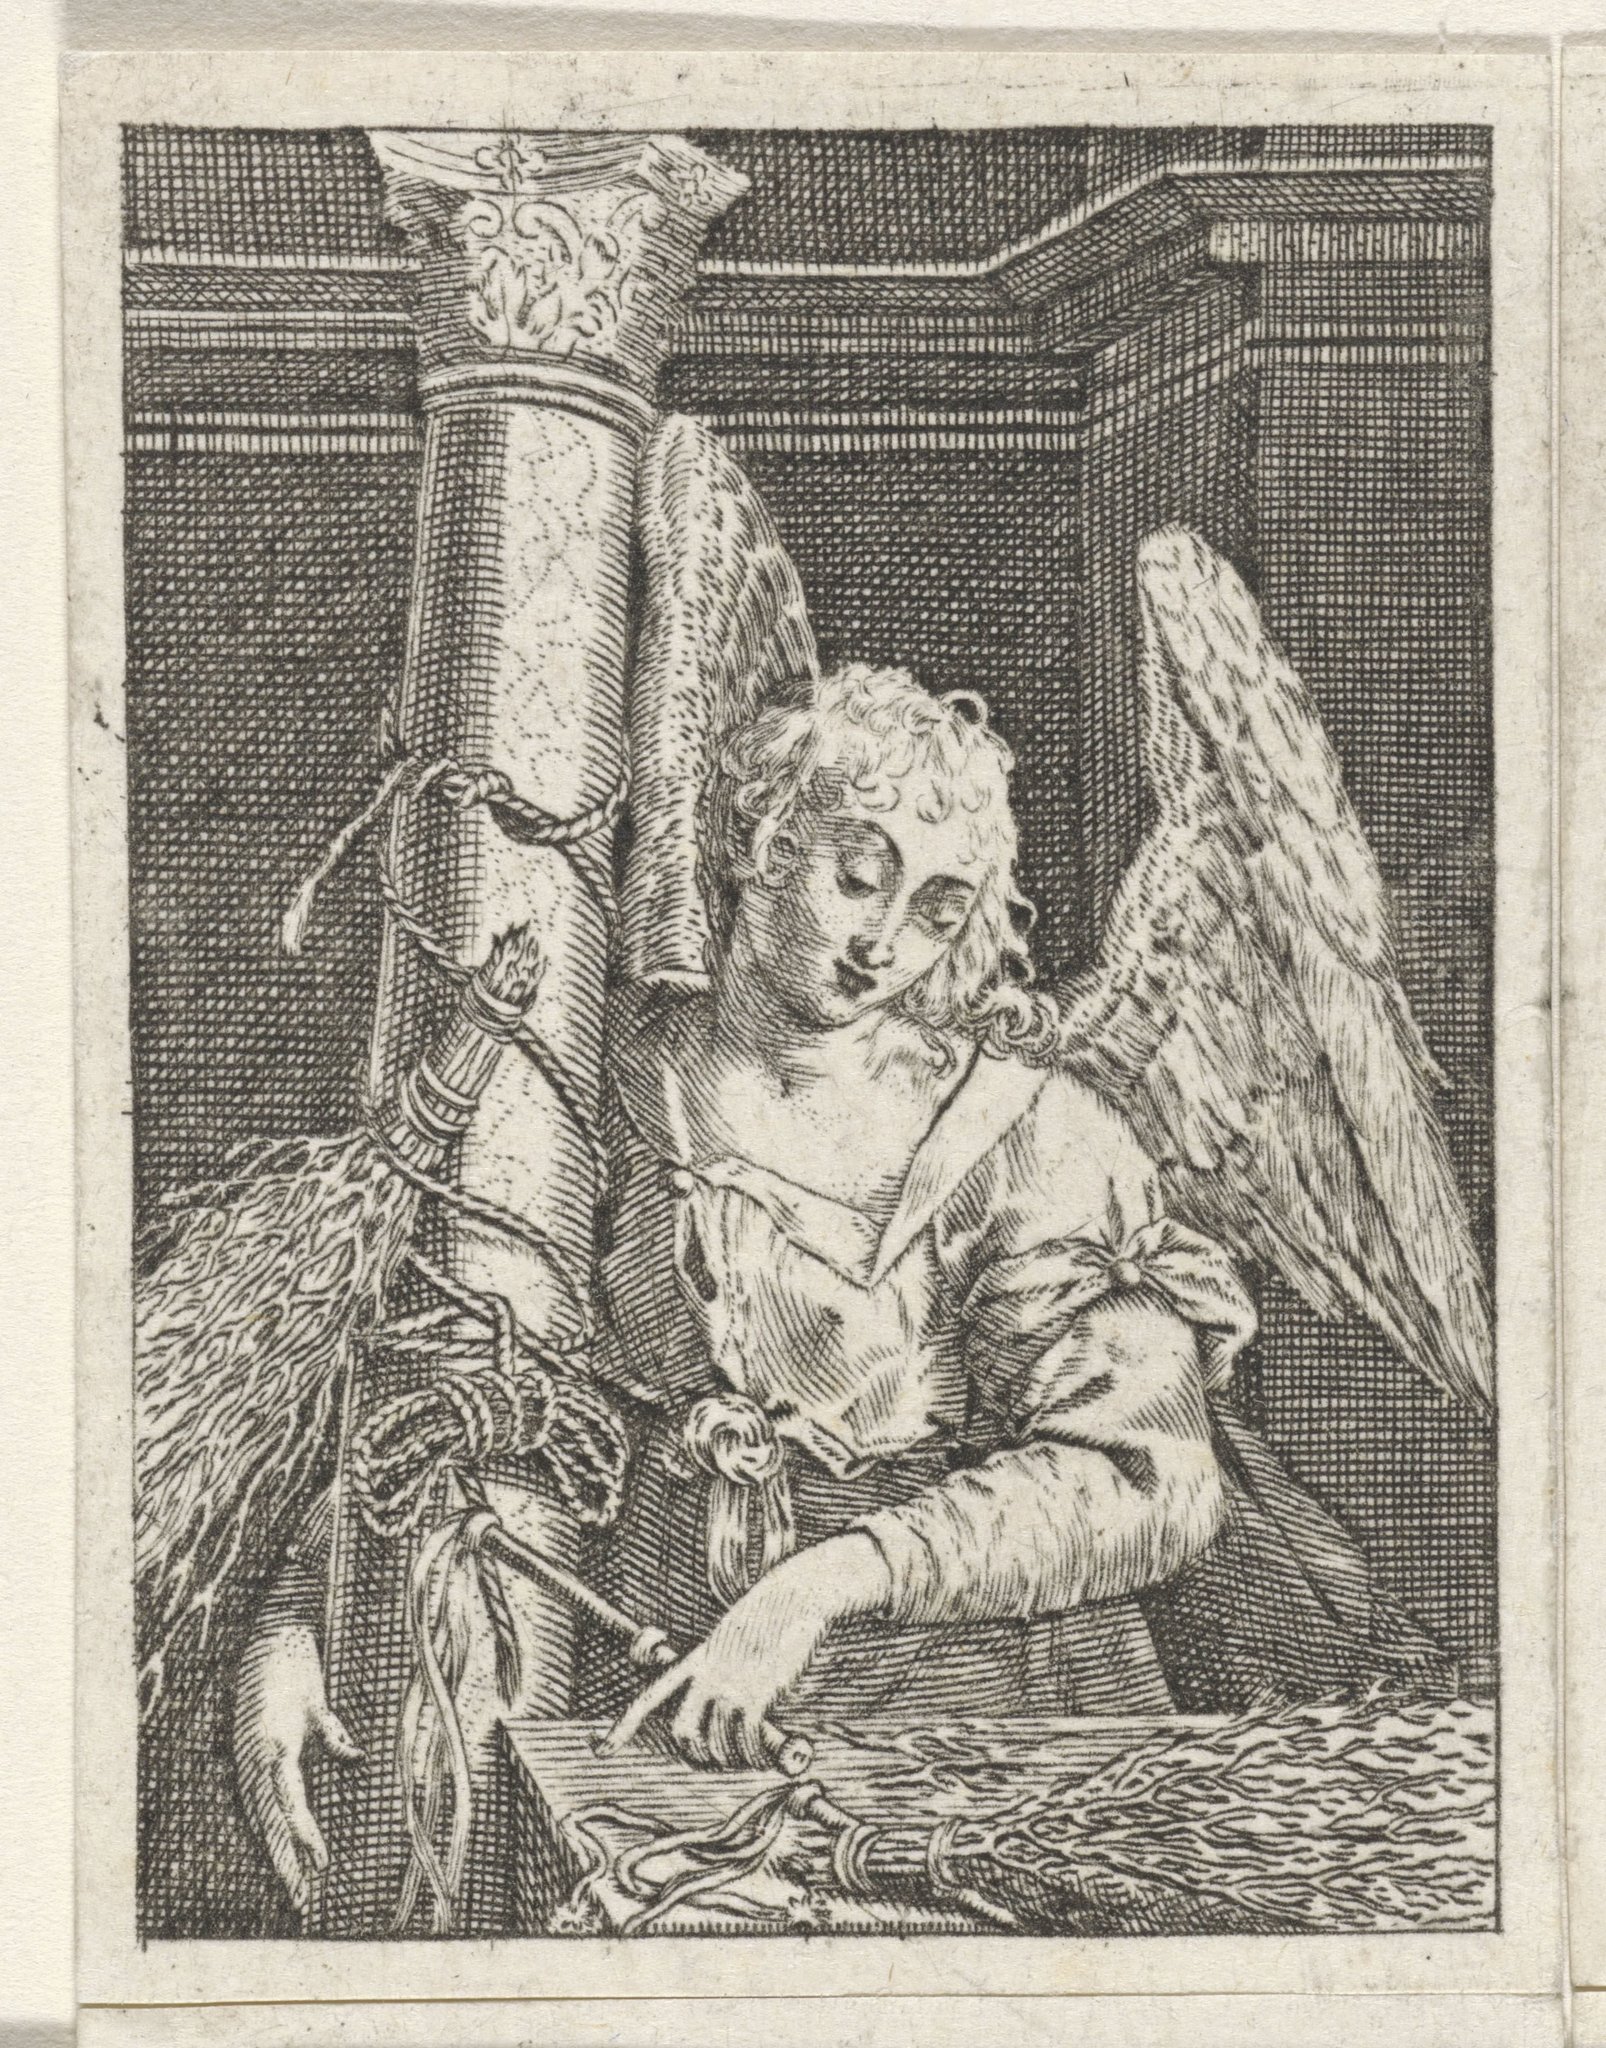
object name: print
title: Engel met de zuil, roede en zweep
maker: johann sadeler (i)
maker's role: print maker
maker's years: 1550-1600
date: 1580-1600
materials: paper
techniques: engraving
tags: single instruments of the passion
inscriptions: collector's mark: Lugt 240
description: Passiewerktuigen zijn kopie in spiegelbeeld.